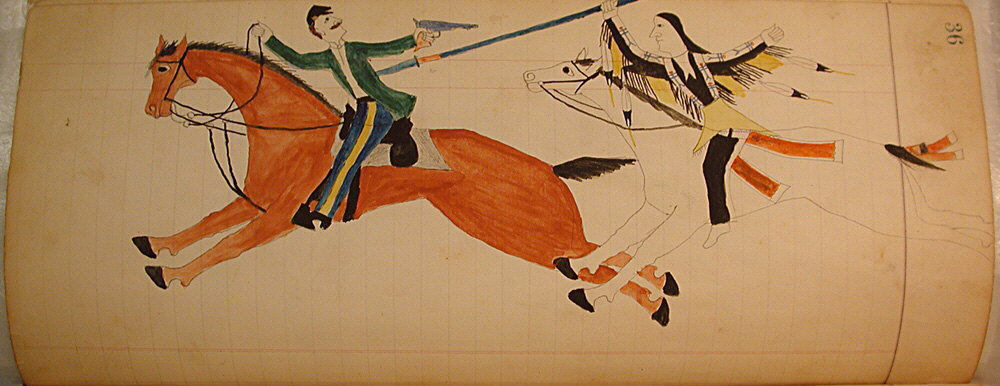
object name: drawing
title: Maffet Ledger: Indian and soldier on horseback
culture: cheyenne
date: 1874-1881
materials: crayon, graphite, paper, watercolor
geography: united states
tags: soldiers,firearms,men,horses